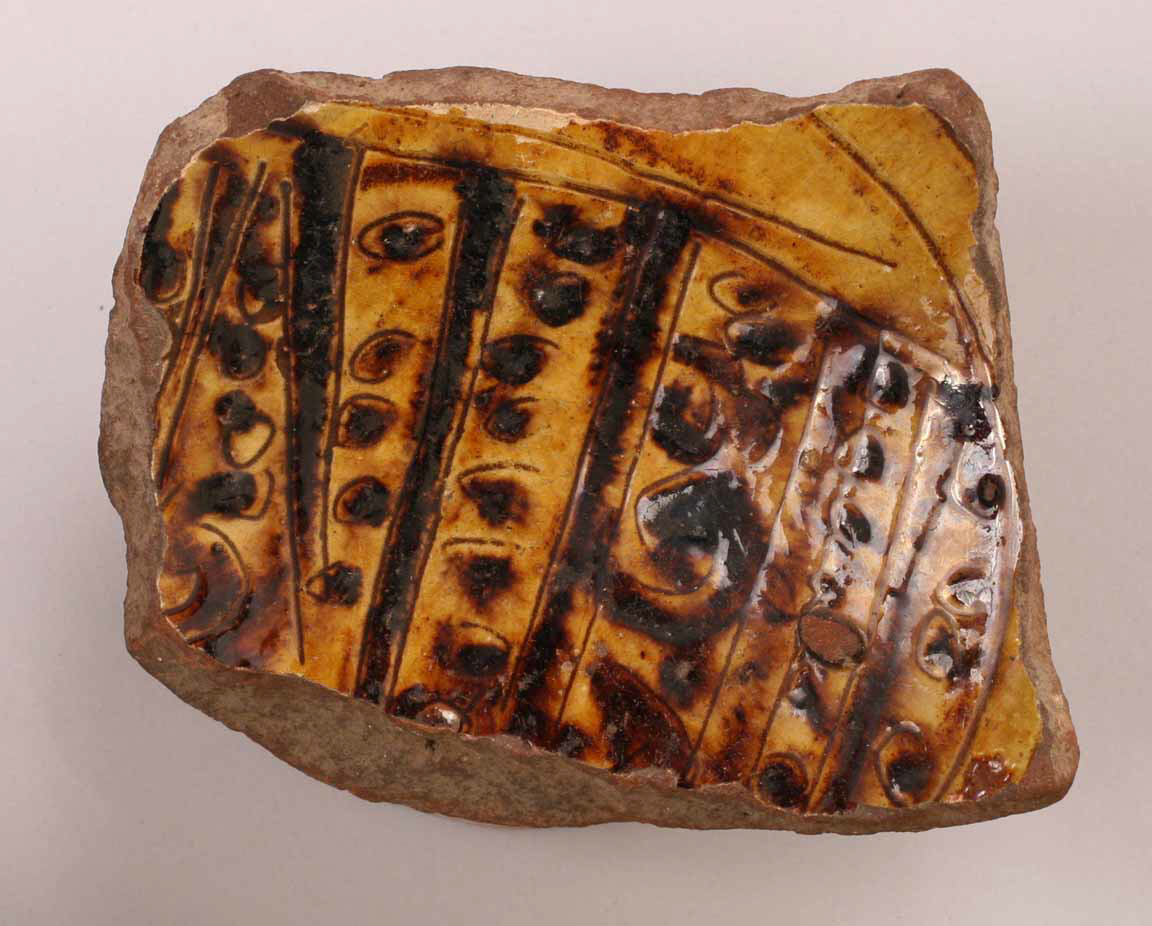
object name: ceramic fragment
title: Fragment of a Bowl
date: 1301-1500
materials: earthenware, glaze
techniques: coloring, incising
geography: egypt